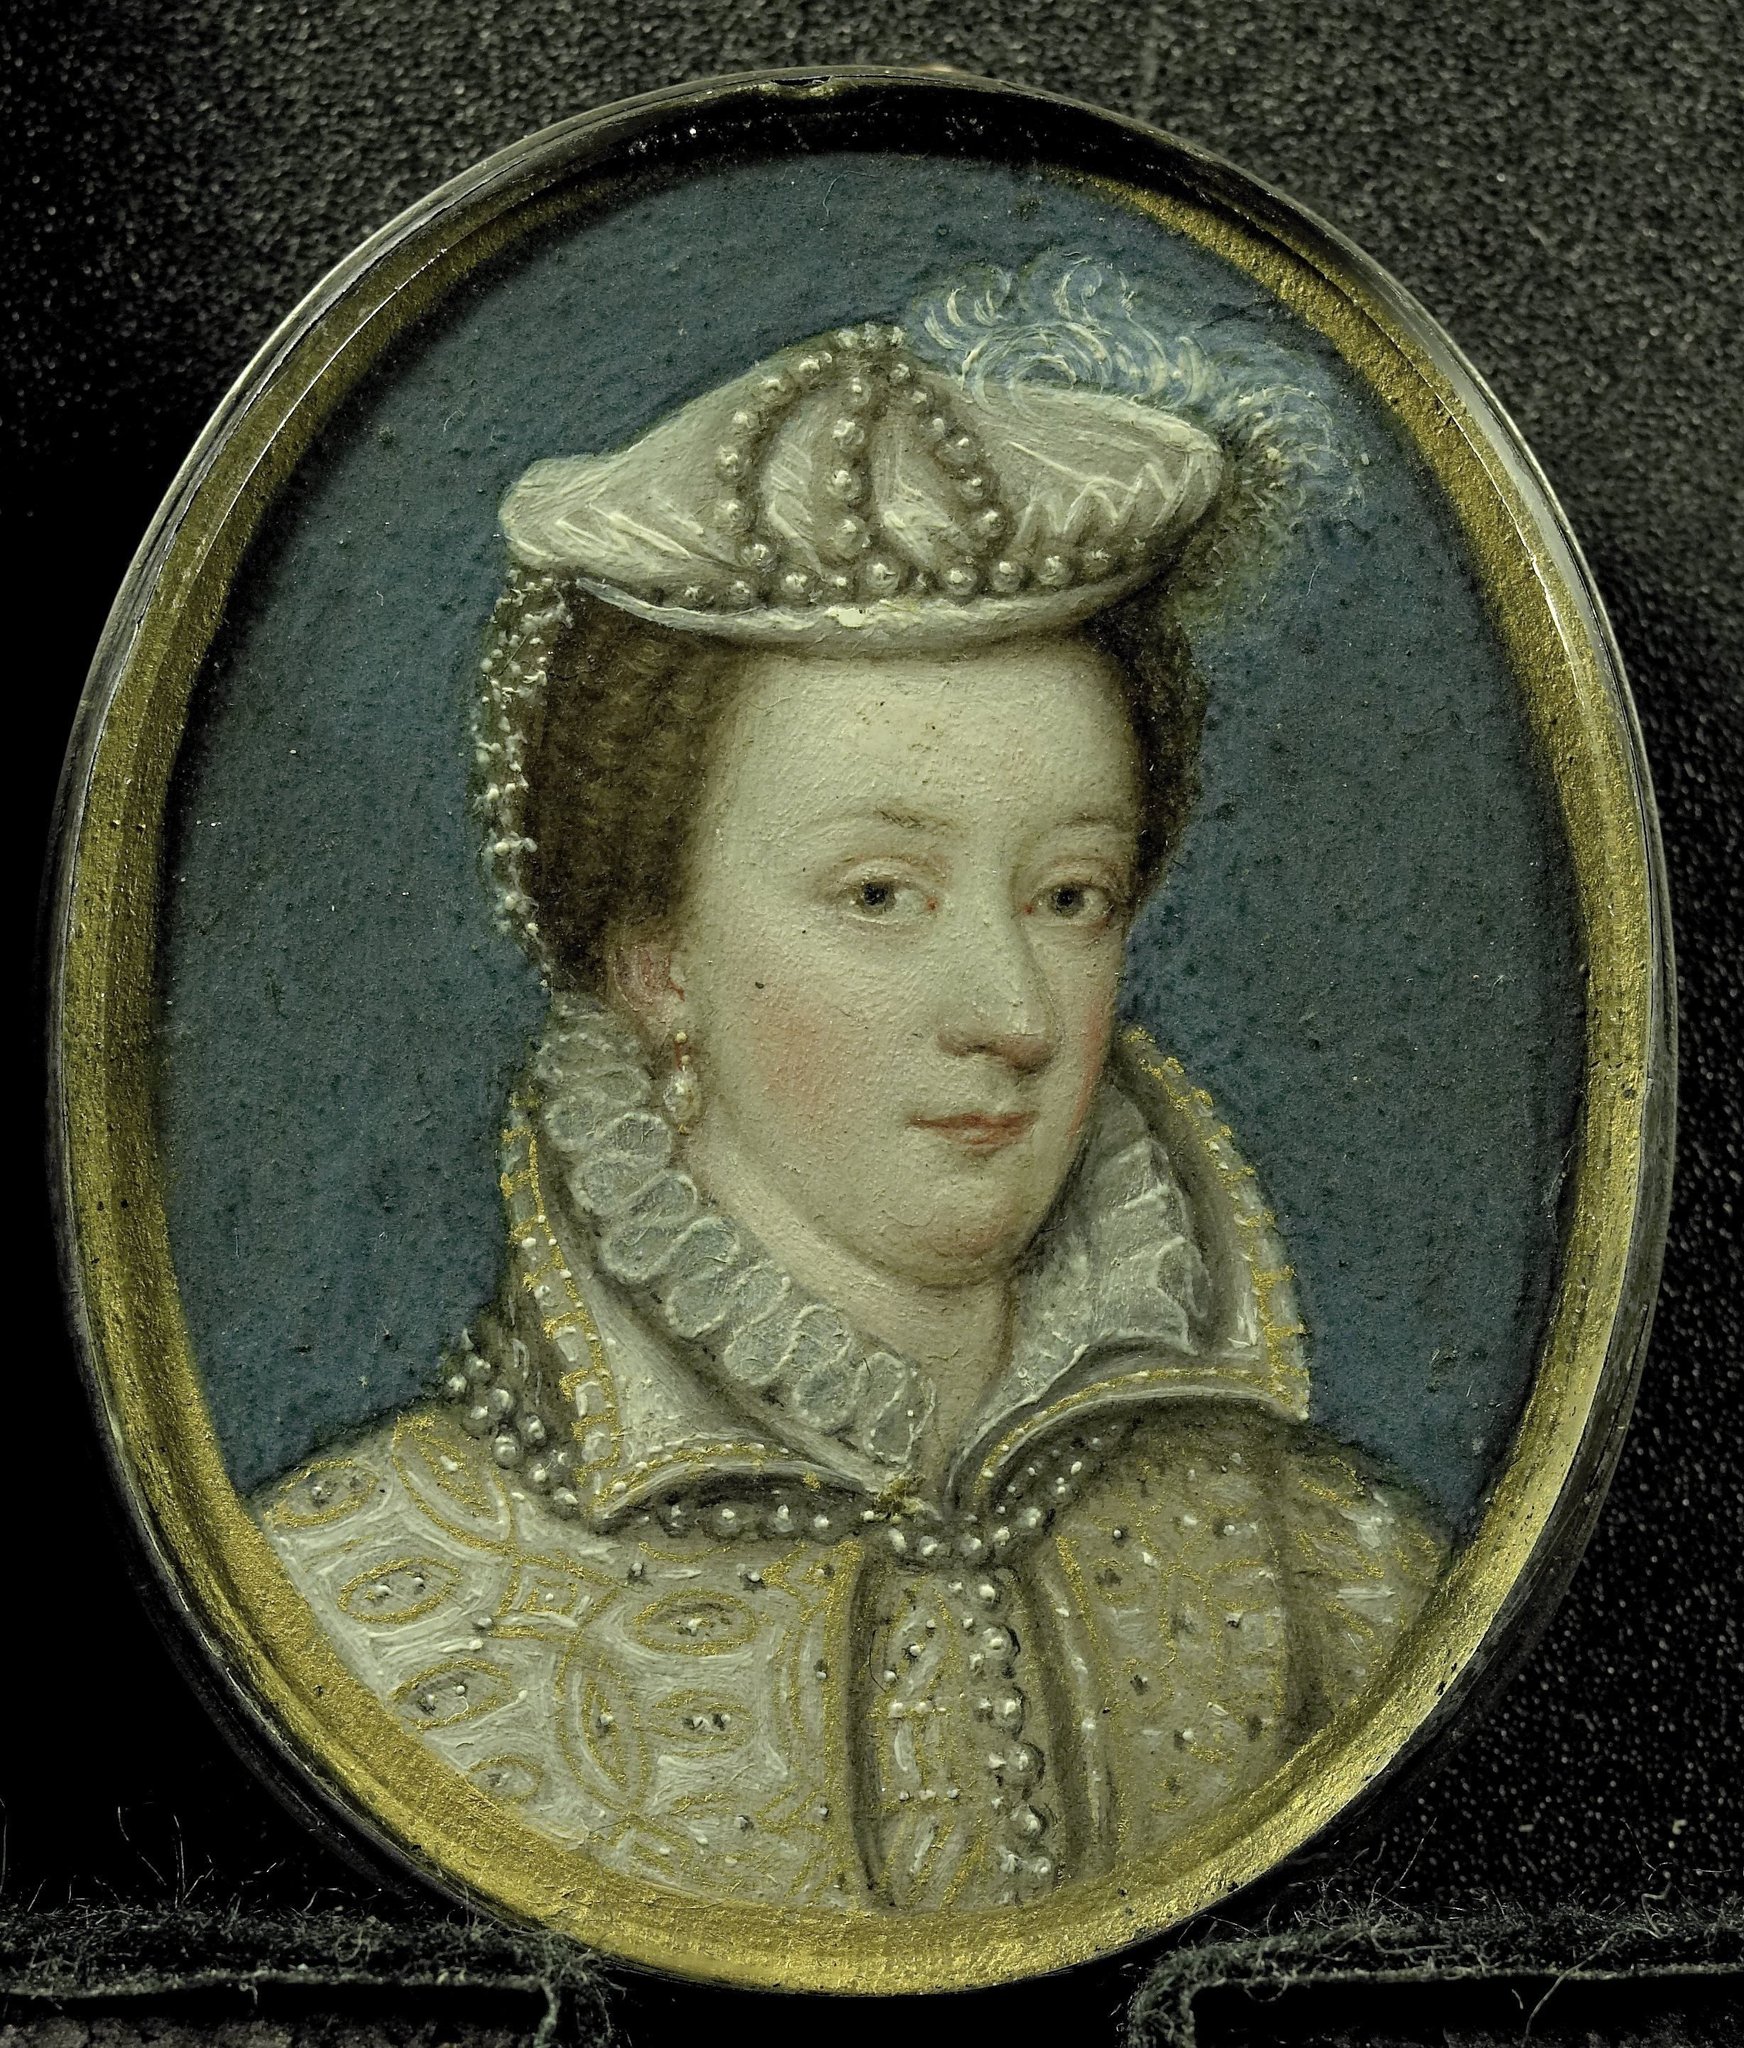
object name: painting, miniature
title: Portret van een vrouw, vermoedelijk Maria Stuart (1542-87), koningin van Schotland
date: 1800-1899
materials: copper, glass, oil, silver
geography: england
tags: fotheringay castle, maria i stuart (koningin van schotland)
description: Portret van een vrouw, vermoedelijk Maria Stuart (1542-87), koningin van Schotland. Buste, naar rechts, met gepluimde baret. Waarschijnlijk een 19e-eeuwse kopie naar een origineel in het Uffizi te Florence. Onderdeel van de collectie portretminiaturen.